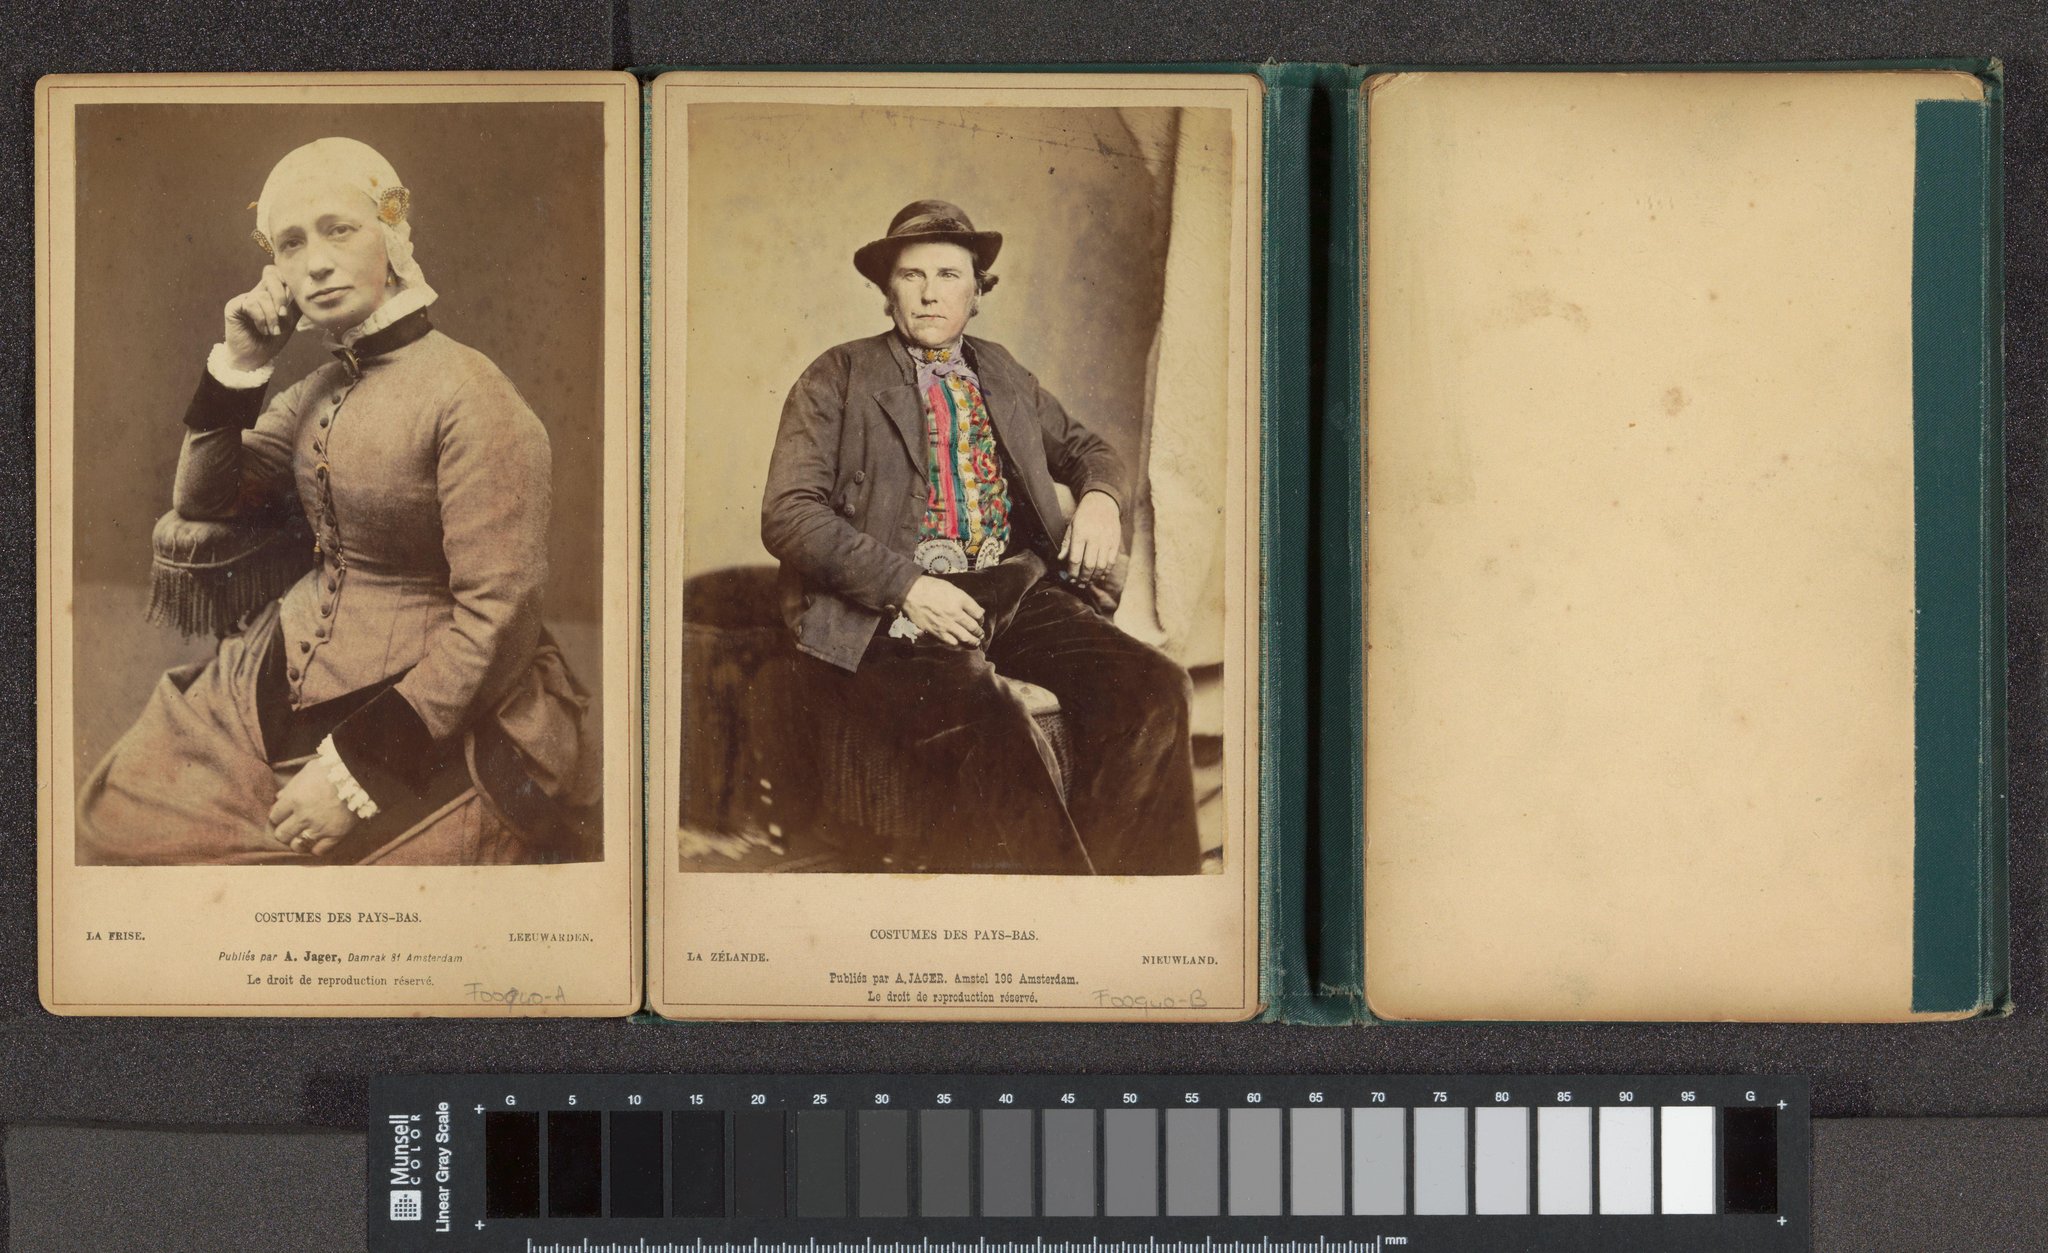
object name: photograph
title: La Zélande. Nieuwland.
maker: andries jager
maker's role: publisher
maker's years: 1825-1905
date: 1870-1890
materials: cardboard, paper, photographic support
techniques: albumen print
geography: amsterdam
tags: studio requisites ~ photographer, folk costume, regional costume (+ men's clothes), folk costume, regional costume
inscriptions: inscription: ‘Costumes des Pays-Bas. Publiés par A. Jager, Damrak 81 Amsterdam Le droit de reproduction réservé.’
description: Onderdeel van Fotoalbum met klederdrachten van Nederland.